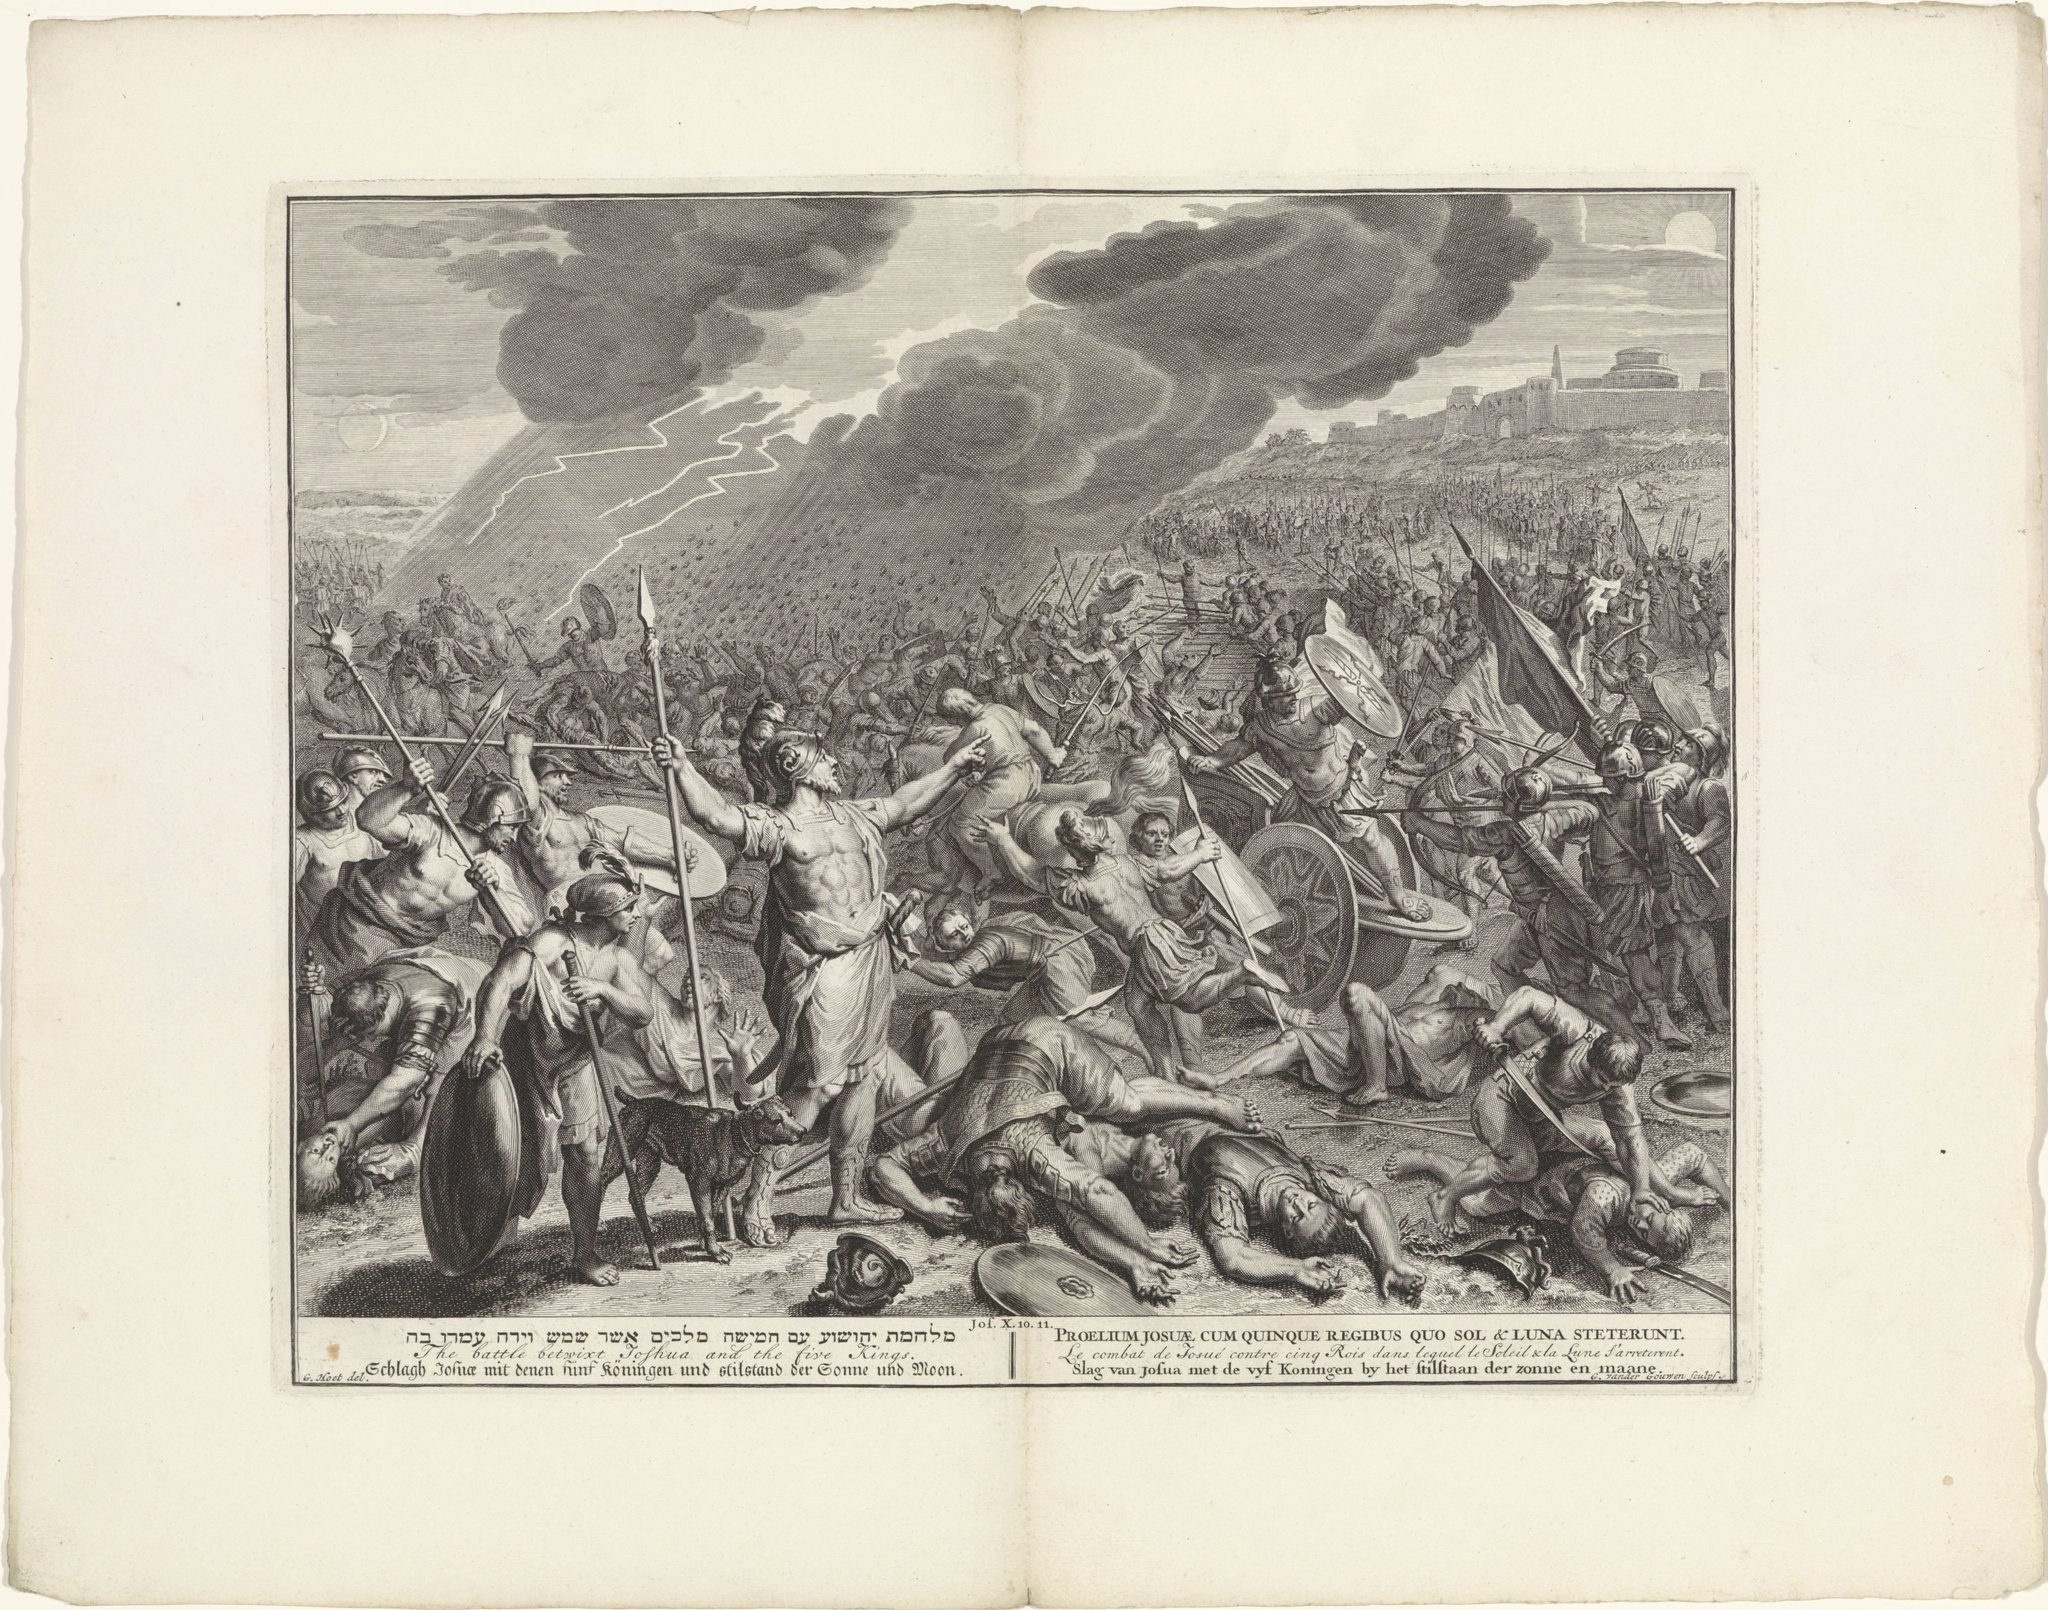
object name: print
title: Slag bij Gibeon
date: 1728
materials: paper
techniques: engraving, etching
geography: amsterdam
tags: joshua and his army make a surprise attack on the amorites who are besieging the city of gibeon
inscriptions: inscription: ‘utrecht fundatiehuys’, collector's mark: Lugt 2228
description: De Israëlieten strijden bij Gibeon tegen de legers van vijf Amoritische koningen. God stuurt hagelstenen en bliksem die de vijand verdrijven. Jozua in wapenuitrusting op de voorgrond. Rechts in de lucht de zon en rechts de maan. (Joz. 10:10-11). De prent heeft een Hebreeuws, Latijns, Frans, Engels, Duits en Nederlands onderschrift.